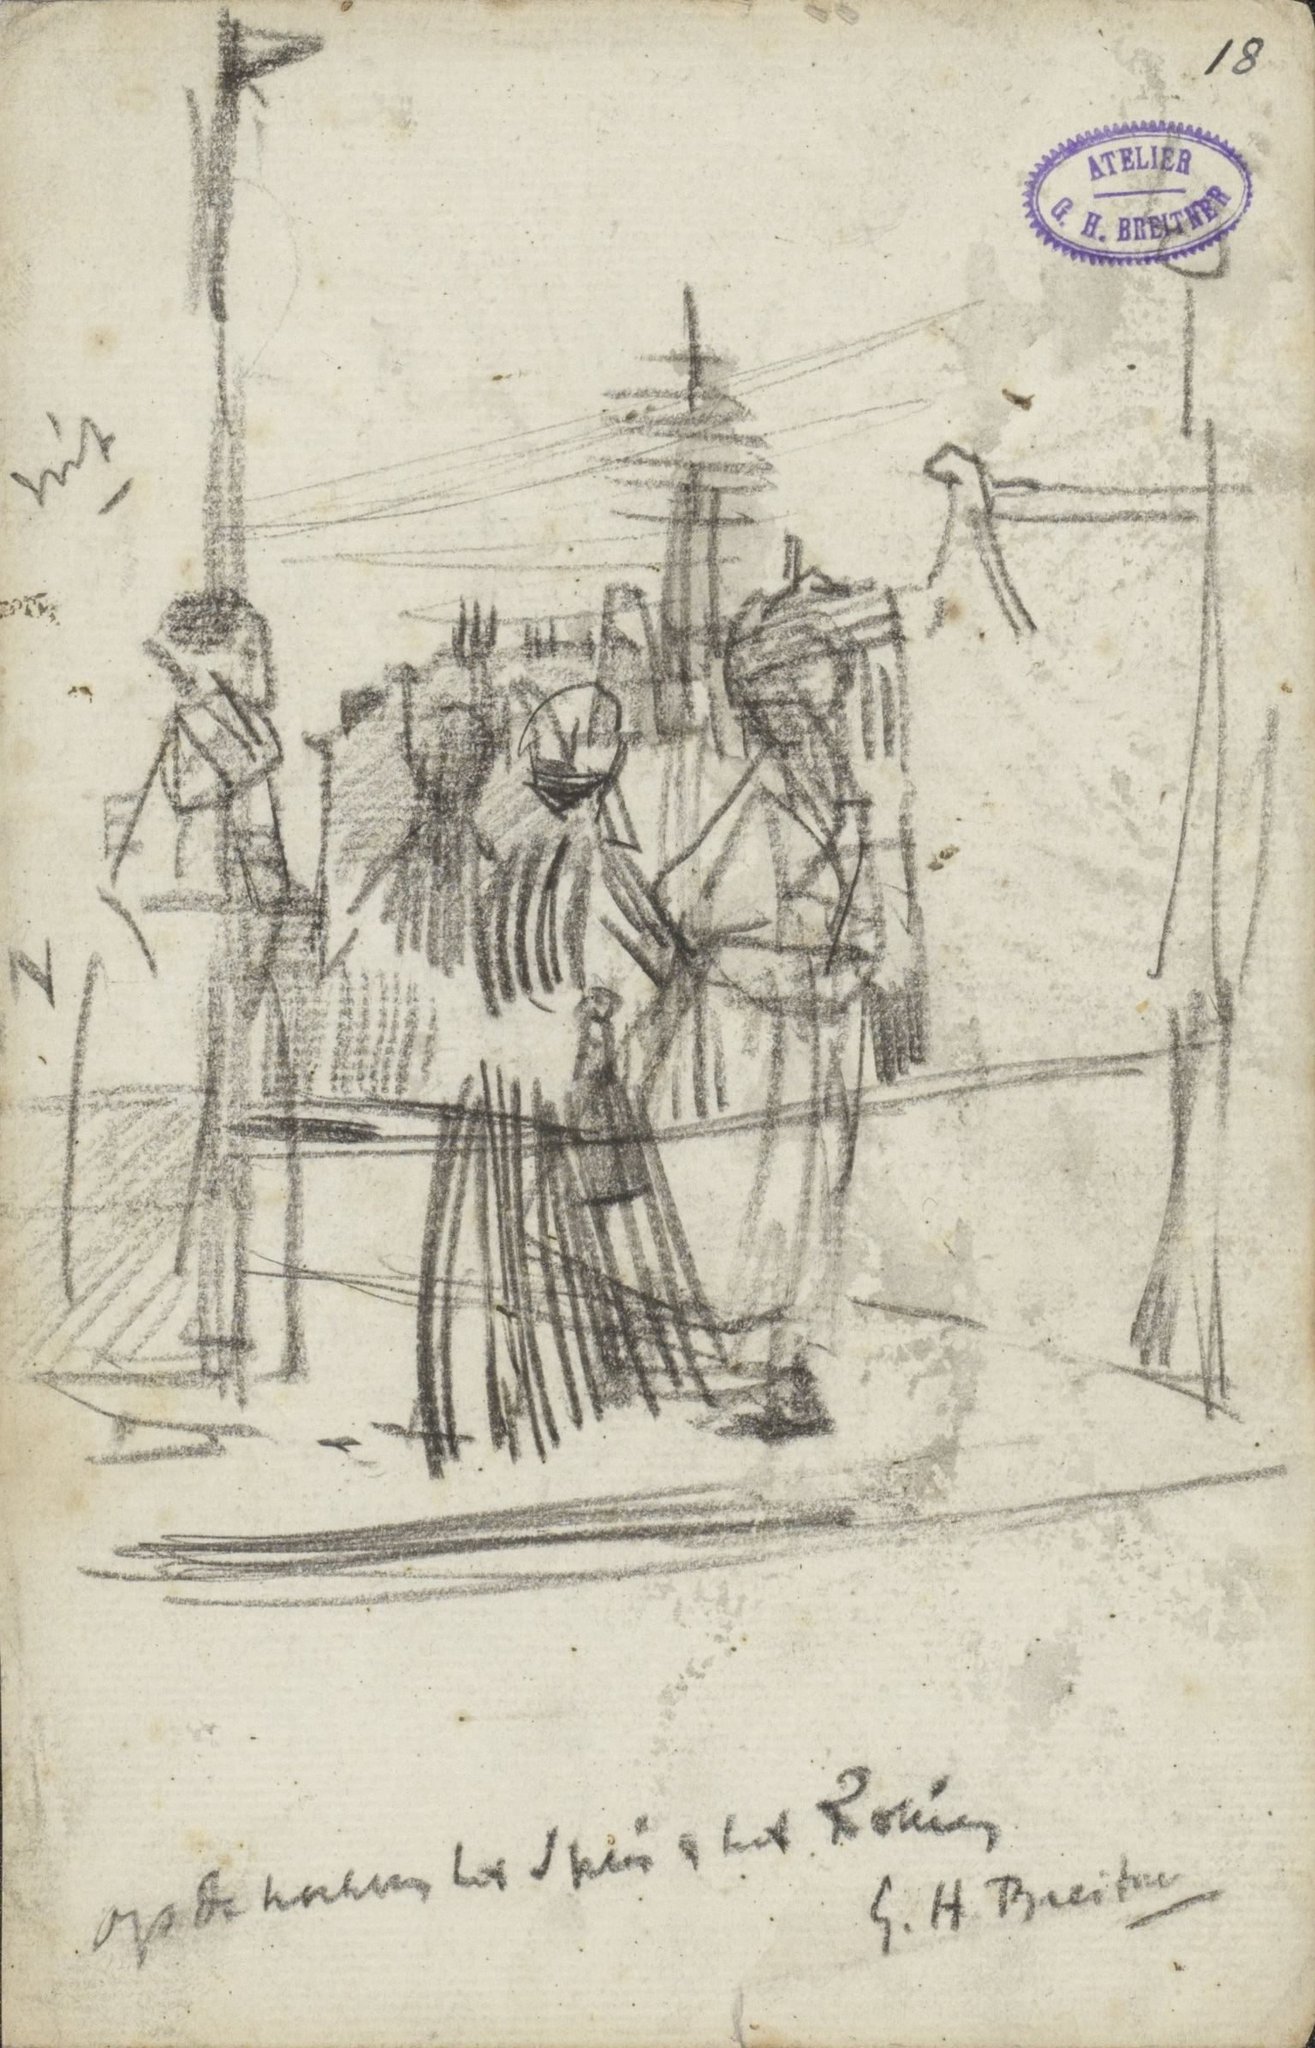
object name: drawing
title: Brug met figuren op de hoek van het Spui en het Rokin te Amsterdam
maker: george hendrik breitner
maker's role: draughtsman, painter, print maker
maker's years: 1857-1923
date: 1886-1923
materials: chalk, paper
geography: amsterdam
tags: urban housing, bridge in city across river, canal, etc. (+ city(-scape) with figures, staffage)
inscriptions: collector's mark: Lugt 2228, annotation: ‘op de hoek van het Spui & het Rokin’, : ‘wit’, signature: ‘G.H. Breitner’, workshop stamp: Lugt 291d